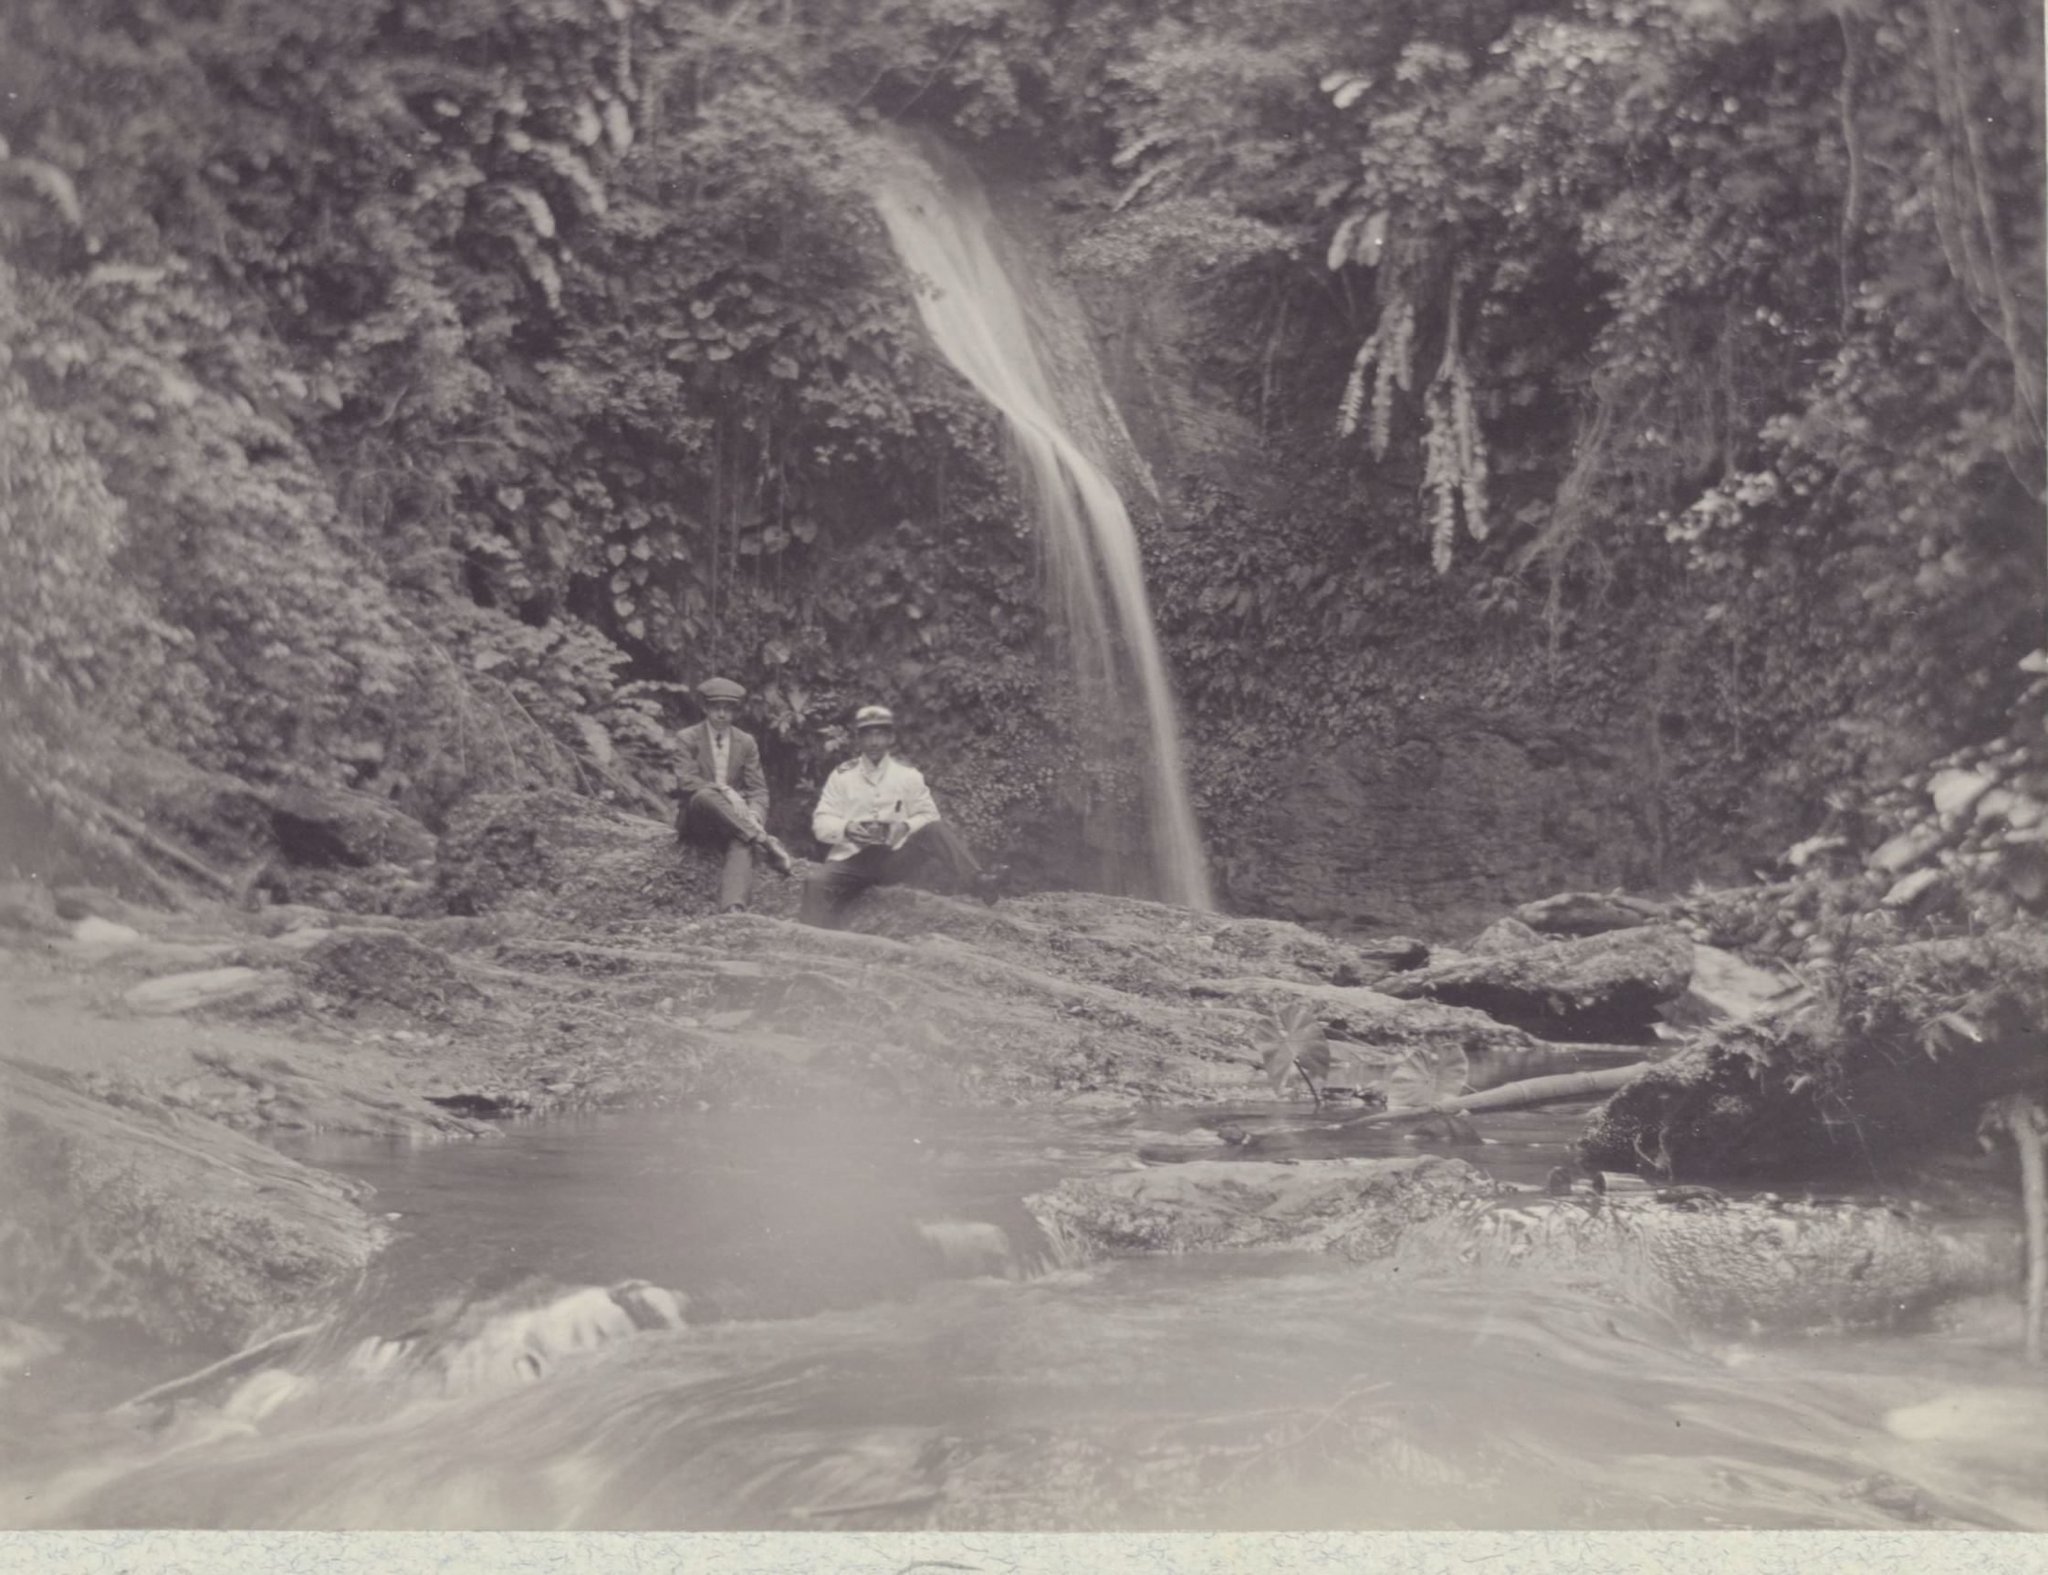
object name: photograph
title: Blue Basin op Trinidad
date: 1901-1911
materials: photographic support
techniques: photography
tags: waterfall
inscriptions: inscription: ‘Watervalletje op Trinidad "Blue Basin". Jan. 11.’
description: Een kleine waterval, Blue Basin Falls, op Trinidad, januari 1911. Twee mannen zitten op de rotsen. Onderdeel van het fotoalbum van de familie Boom-Gonggrijp in Suriname en Curaçao.